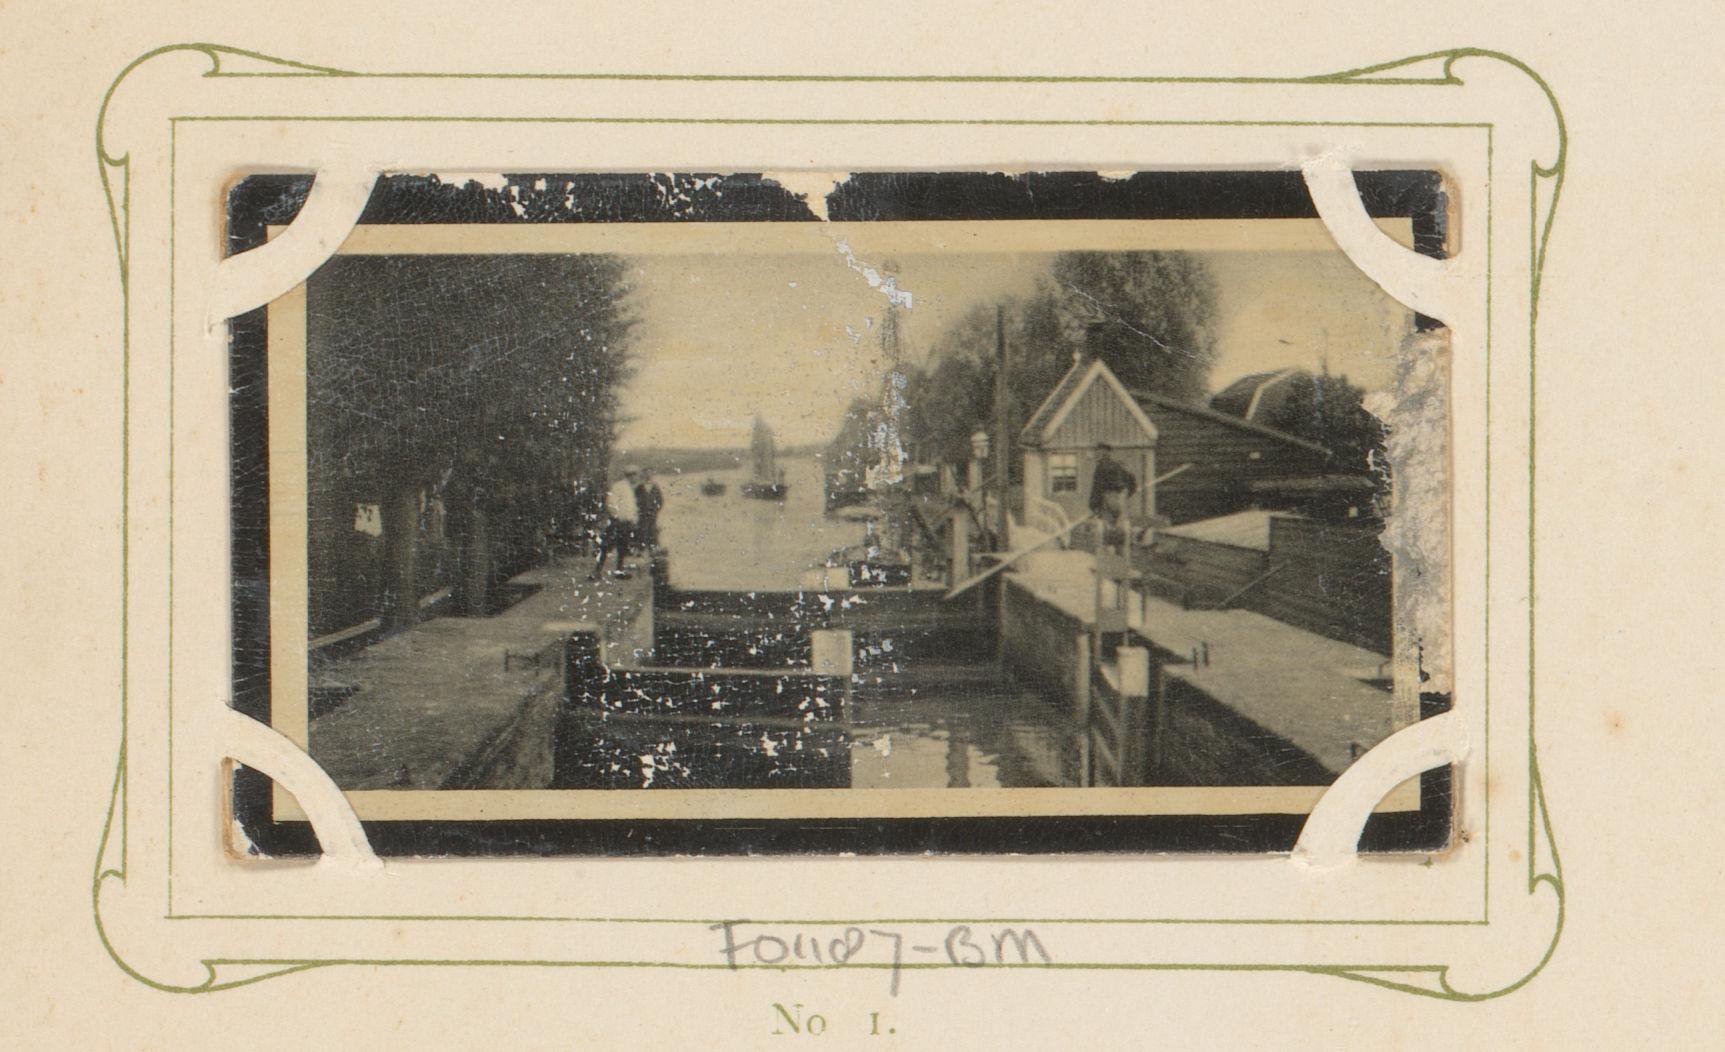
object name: photomechanical print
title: Gezicht op de oostzijde van de Noordervaldeursluis in Zaandam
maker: Anonymous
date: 1905-1906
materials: paper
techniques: photograph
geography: zaandam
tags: sluice, weir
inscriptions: inscription: ‘No. 1./ Noordervaldeursluis Oostzijde.’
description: Deze prent maakt deel uit van een album.